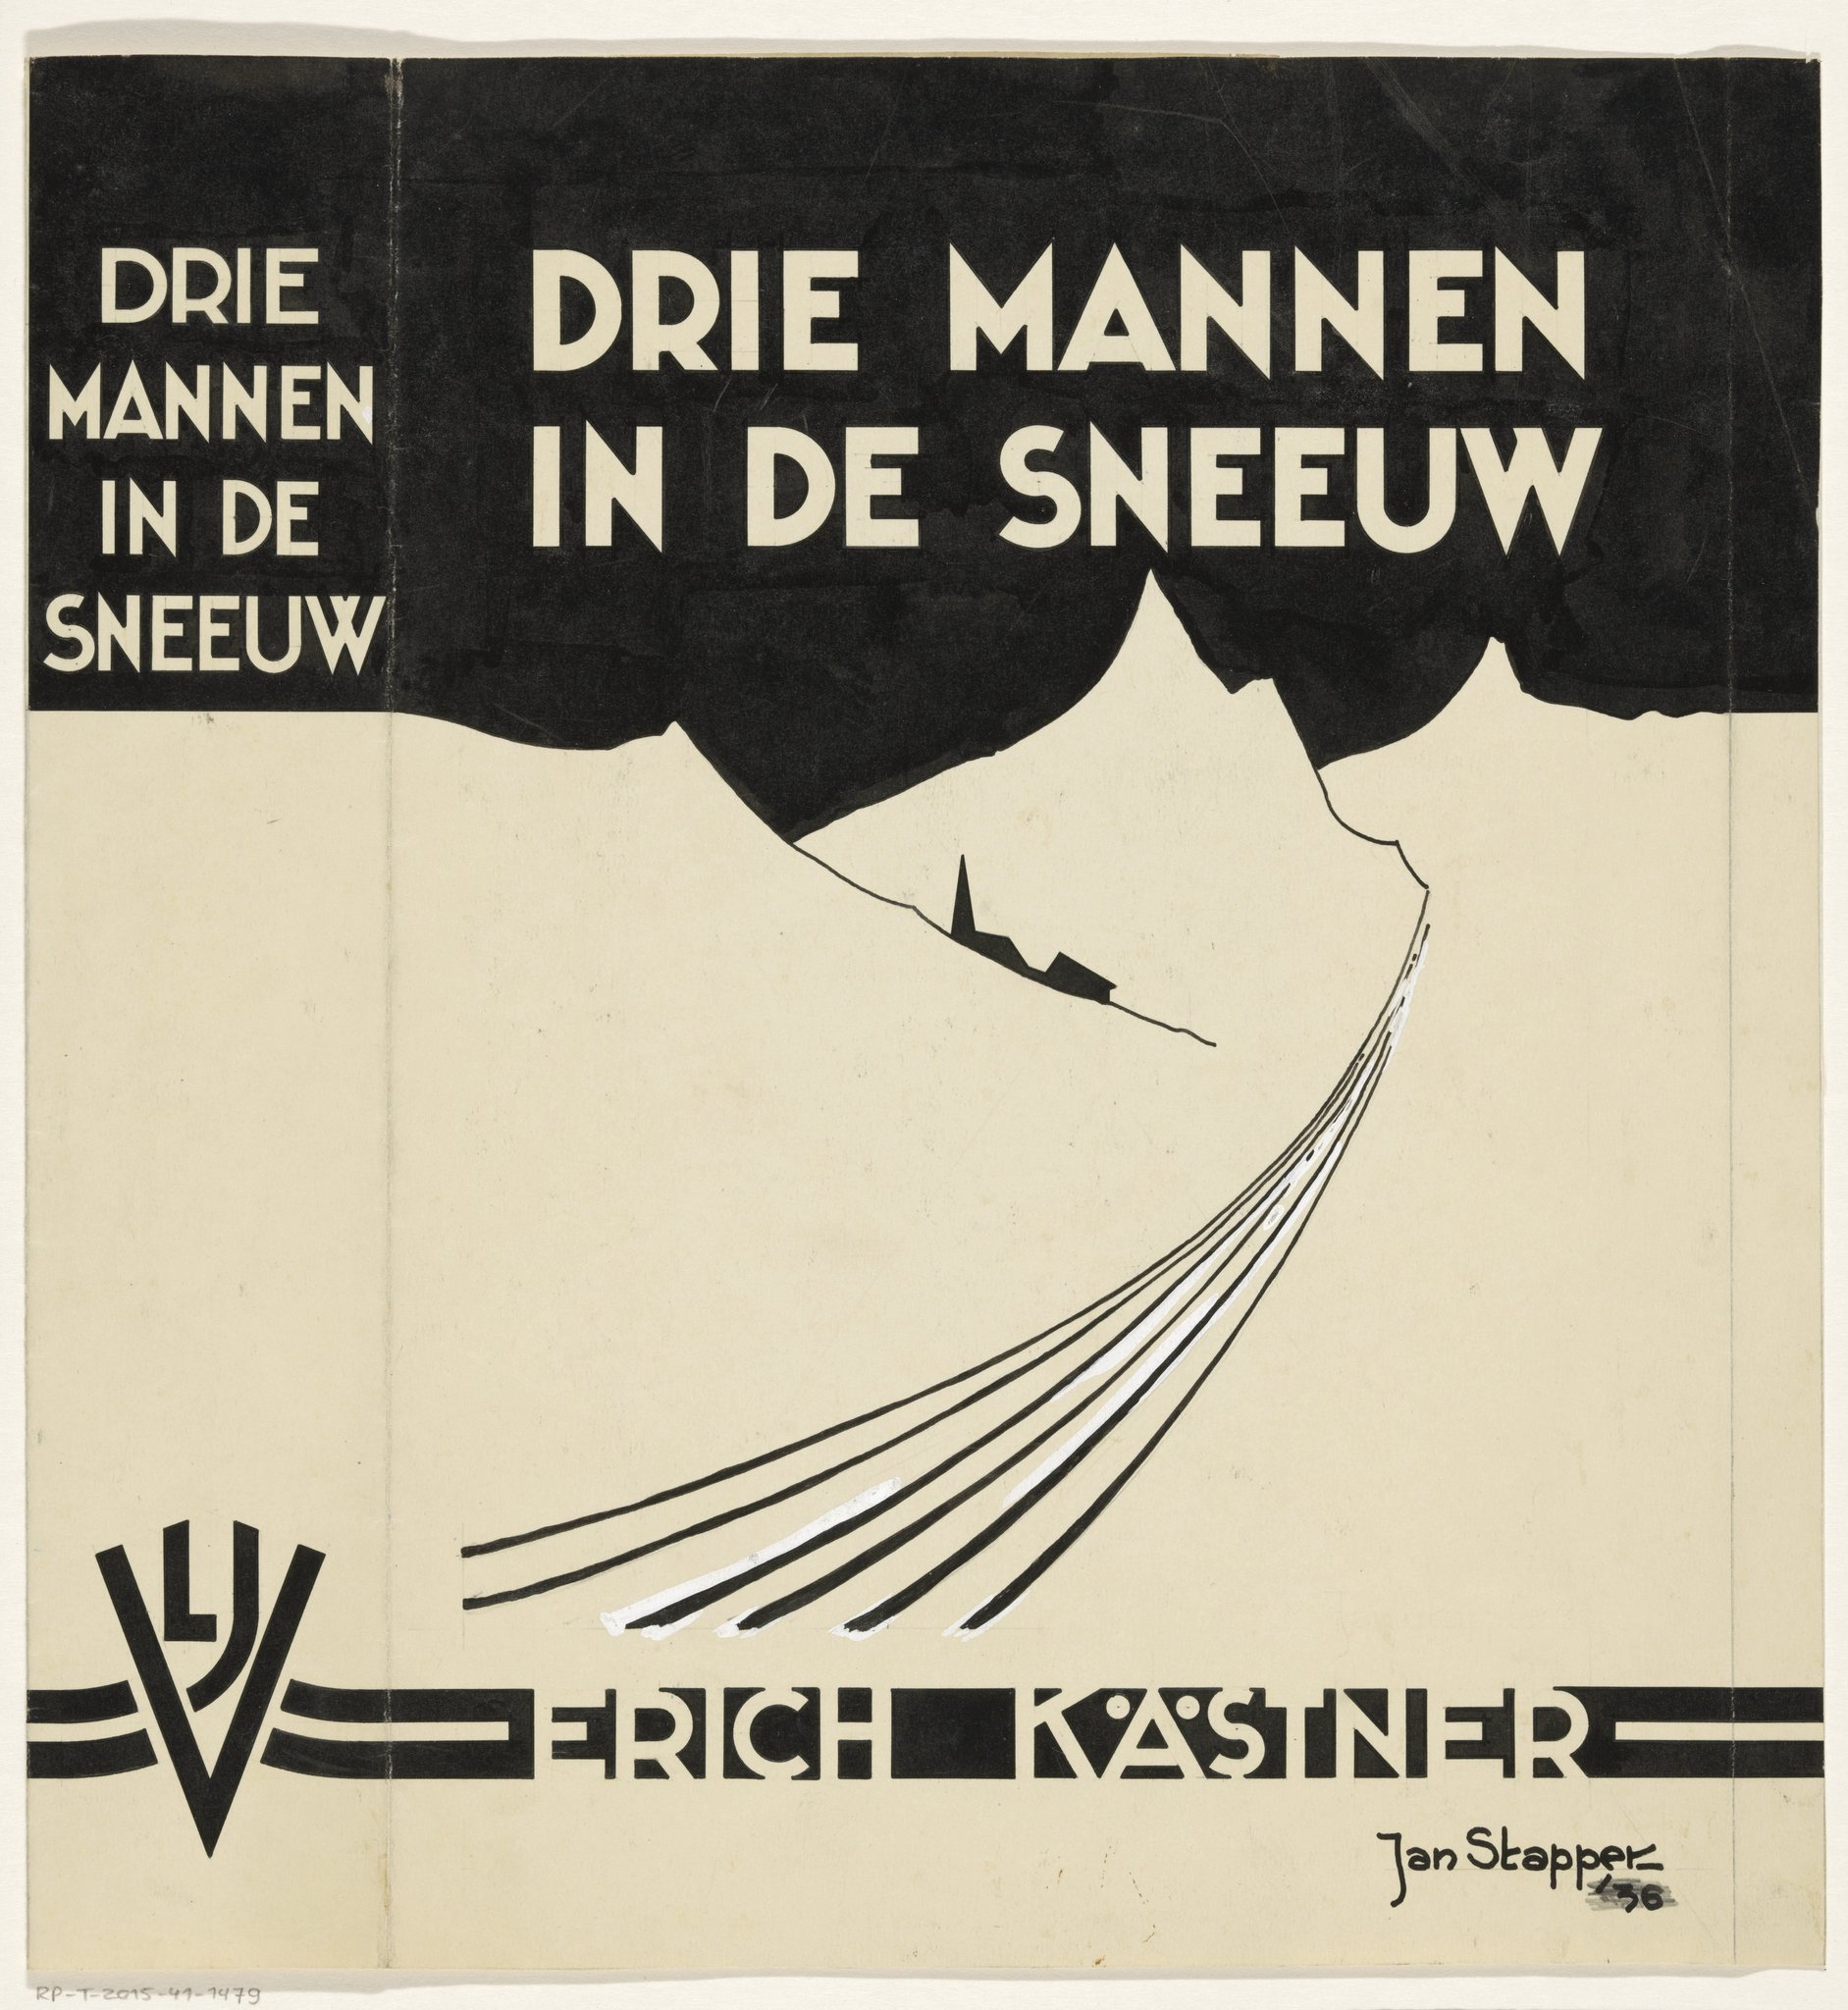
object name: study for binding design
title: Bandontwerp voor: Erich Kästner, Drie mannen in de sneeuw (Drei Männer im Schnee), c. 1935-1939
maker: jan stapper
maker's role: draughtsman, print maker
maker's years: 1875-1964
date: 1936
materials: paint, paper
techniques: brush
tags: road, path, mountain-range, snow peaks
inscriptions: signature and date: ‘Jan Stapper/ '36’, :, collector's mark: Lugt 2228, annotation: ‘6 [...] omslag/ (blauw)/ [...]/ naar L.J. Veen/ Leidschegracht’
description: Besneeuwd berglandschap met zicht op een dorp en een pad of spoor dat richting de bergen loopt.